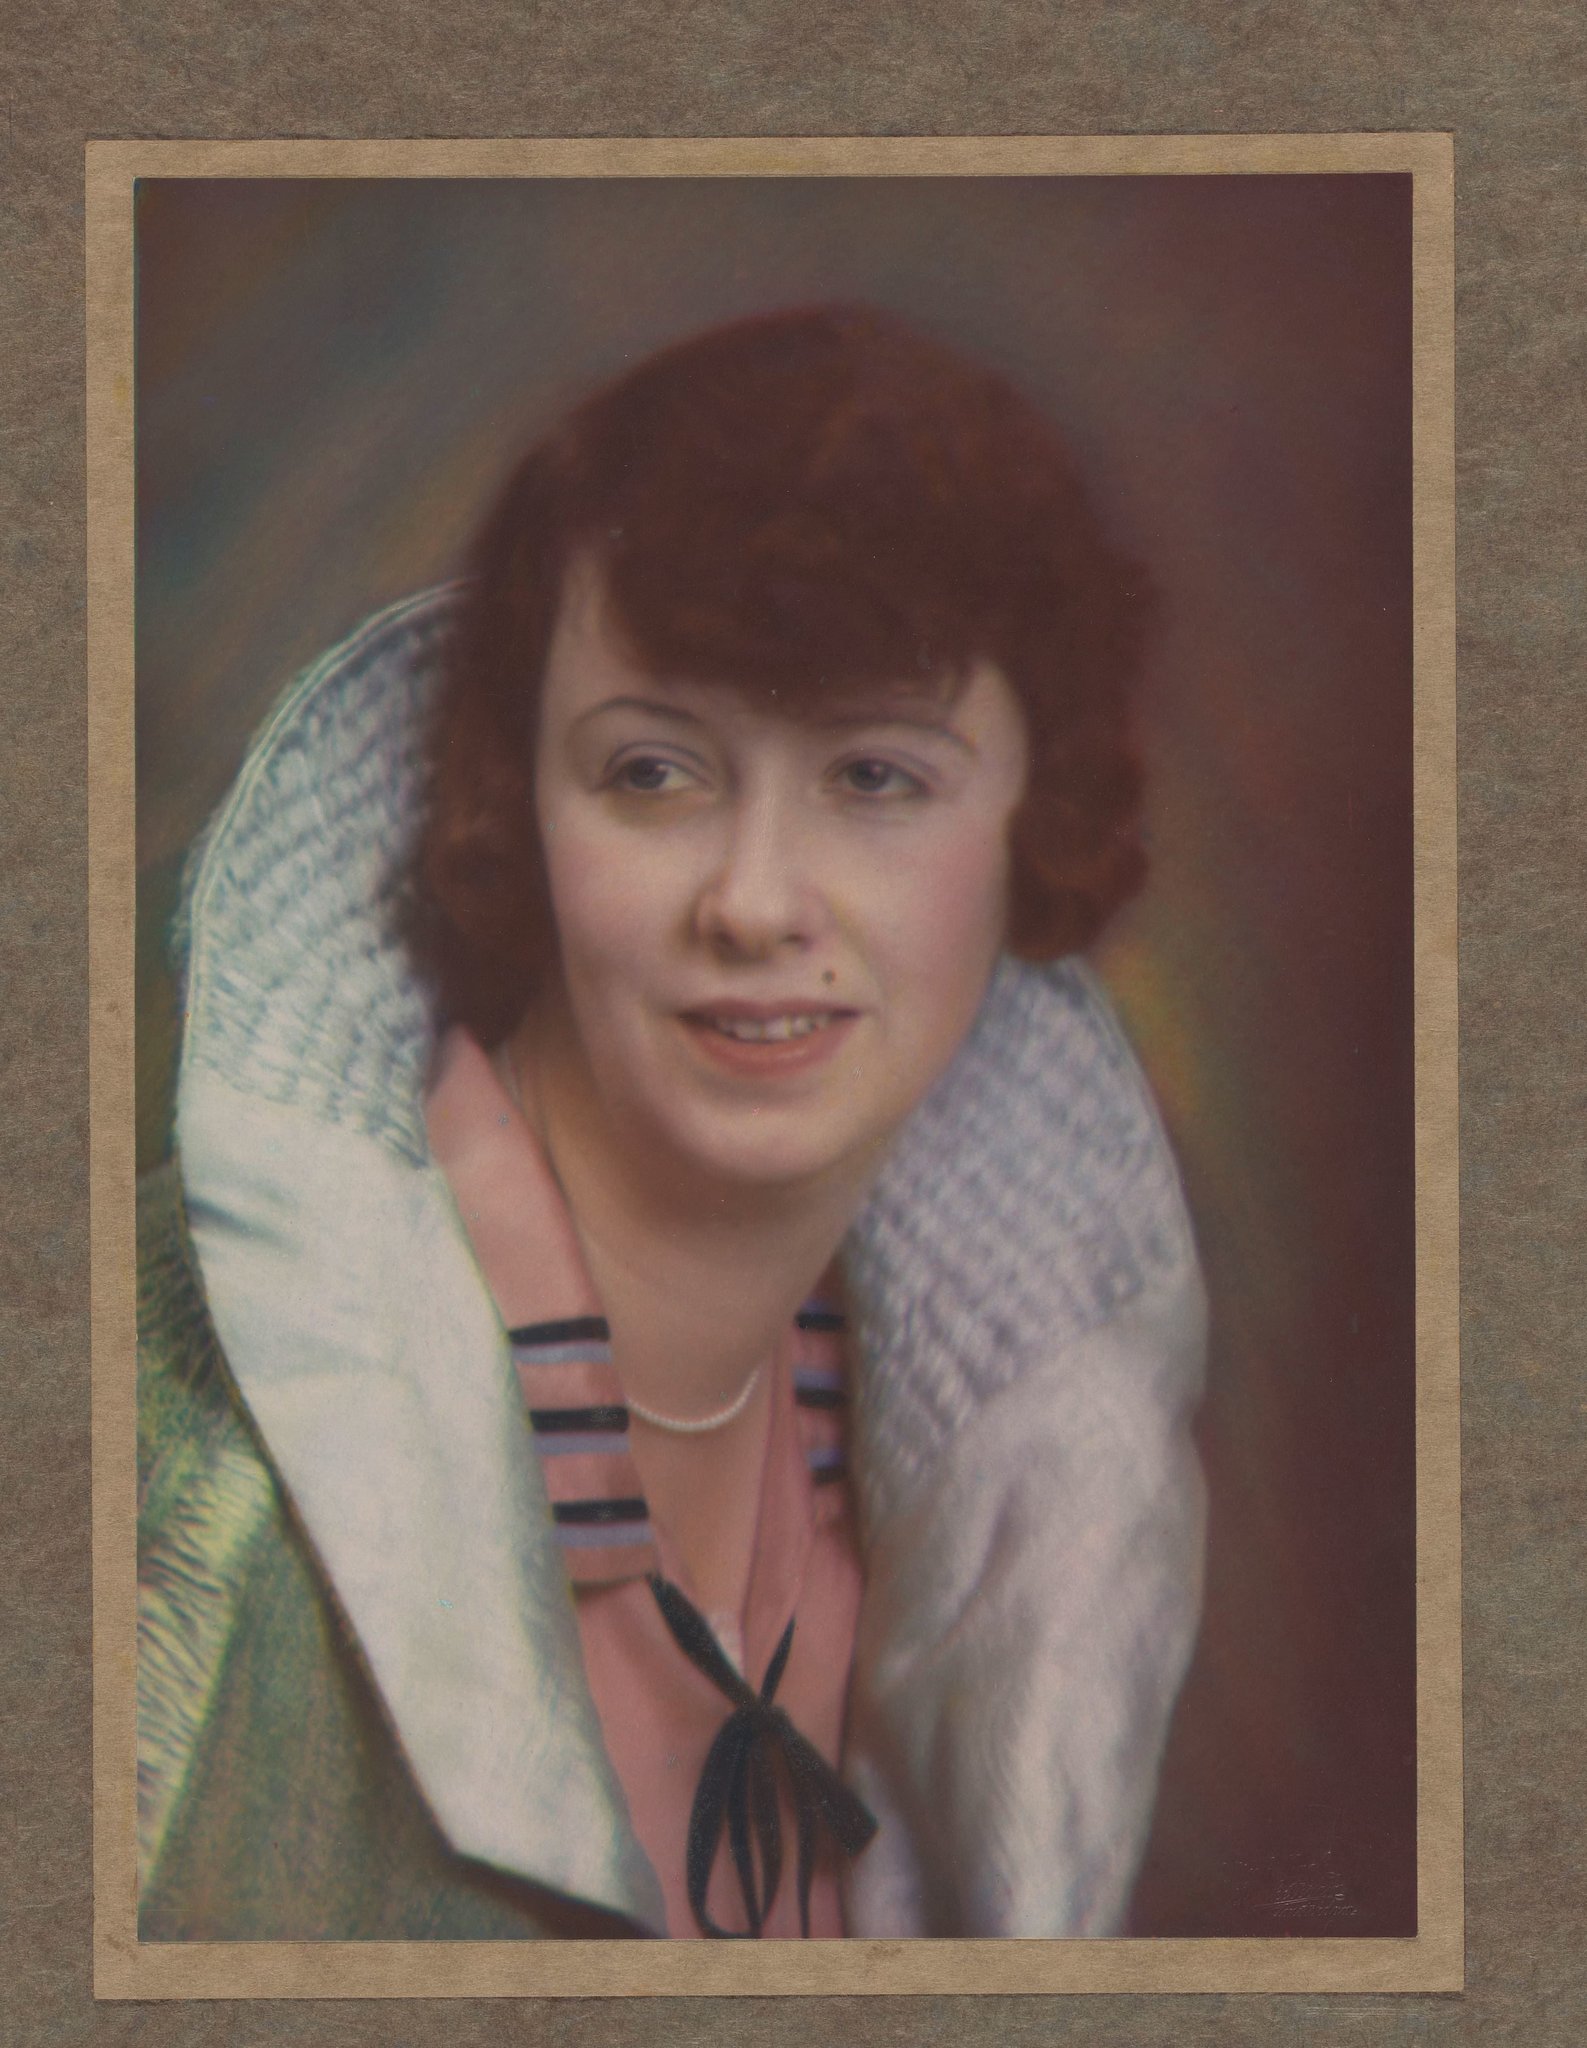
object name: photograph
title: Portret van Jetje van Eeghen-Deterding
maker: jacob merkelbach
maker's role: fotograaf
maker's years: 1877-1942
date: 1925-1940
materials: paper, cardboard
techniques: jos-pé print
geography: amsterdam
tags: historical persons - bb - woman, amsterdam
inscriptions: check stamp: ‘Merkelbach/ Amsterdam’, check stamp: ‘Merkelbach/ Merkelbach/ Amsterdam’